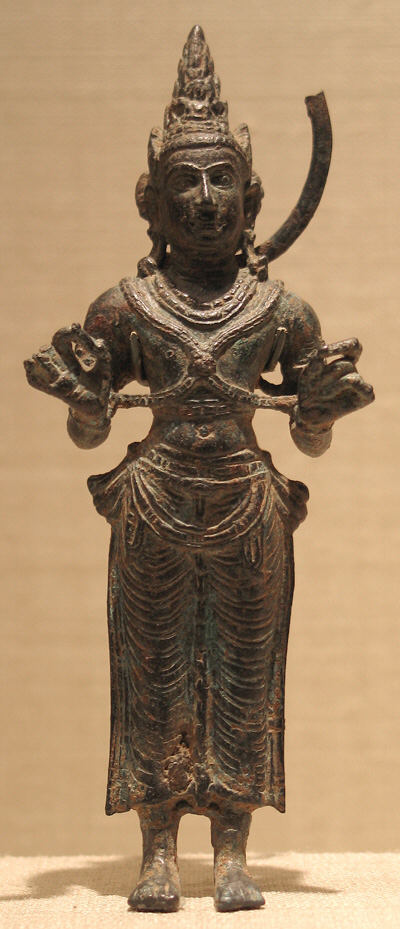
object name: figure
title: Avalokiteshvara, The Bodhisattva of Infinite Compassion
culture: sri lankan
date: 801-900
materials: bronze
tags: avalokiteshvara